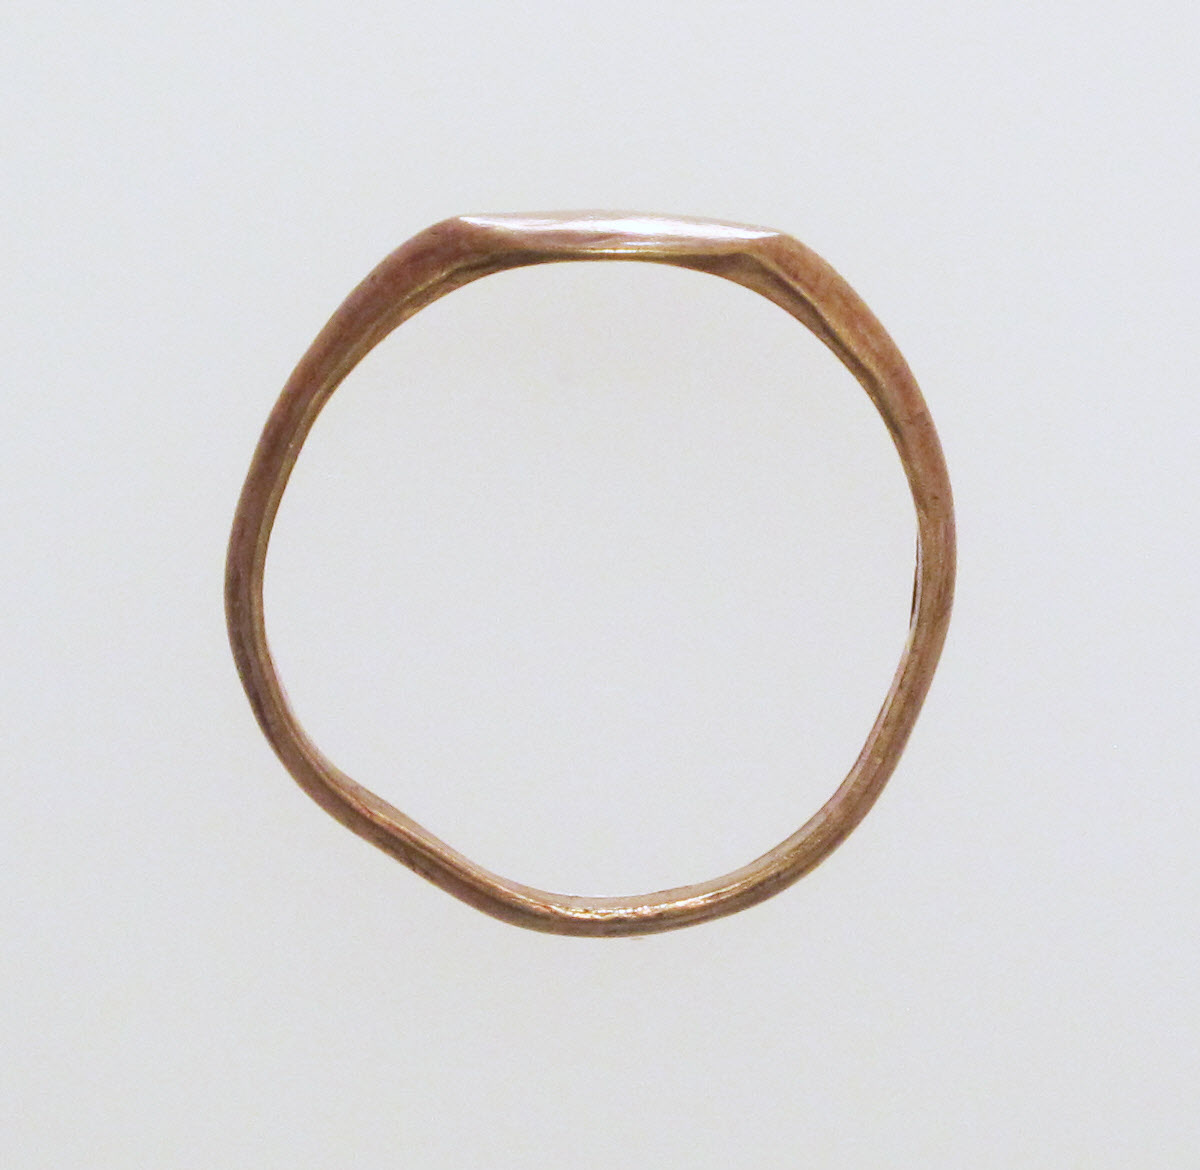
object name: ring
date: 7000 BCE-330 CE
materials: gold